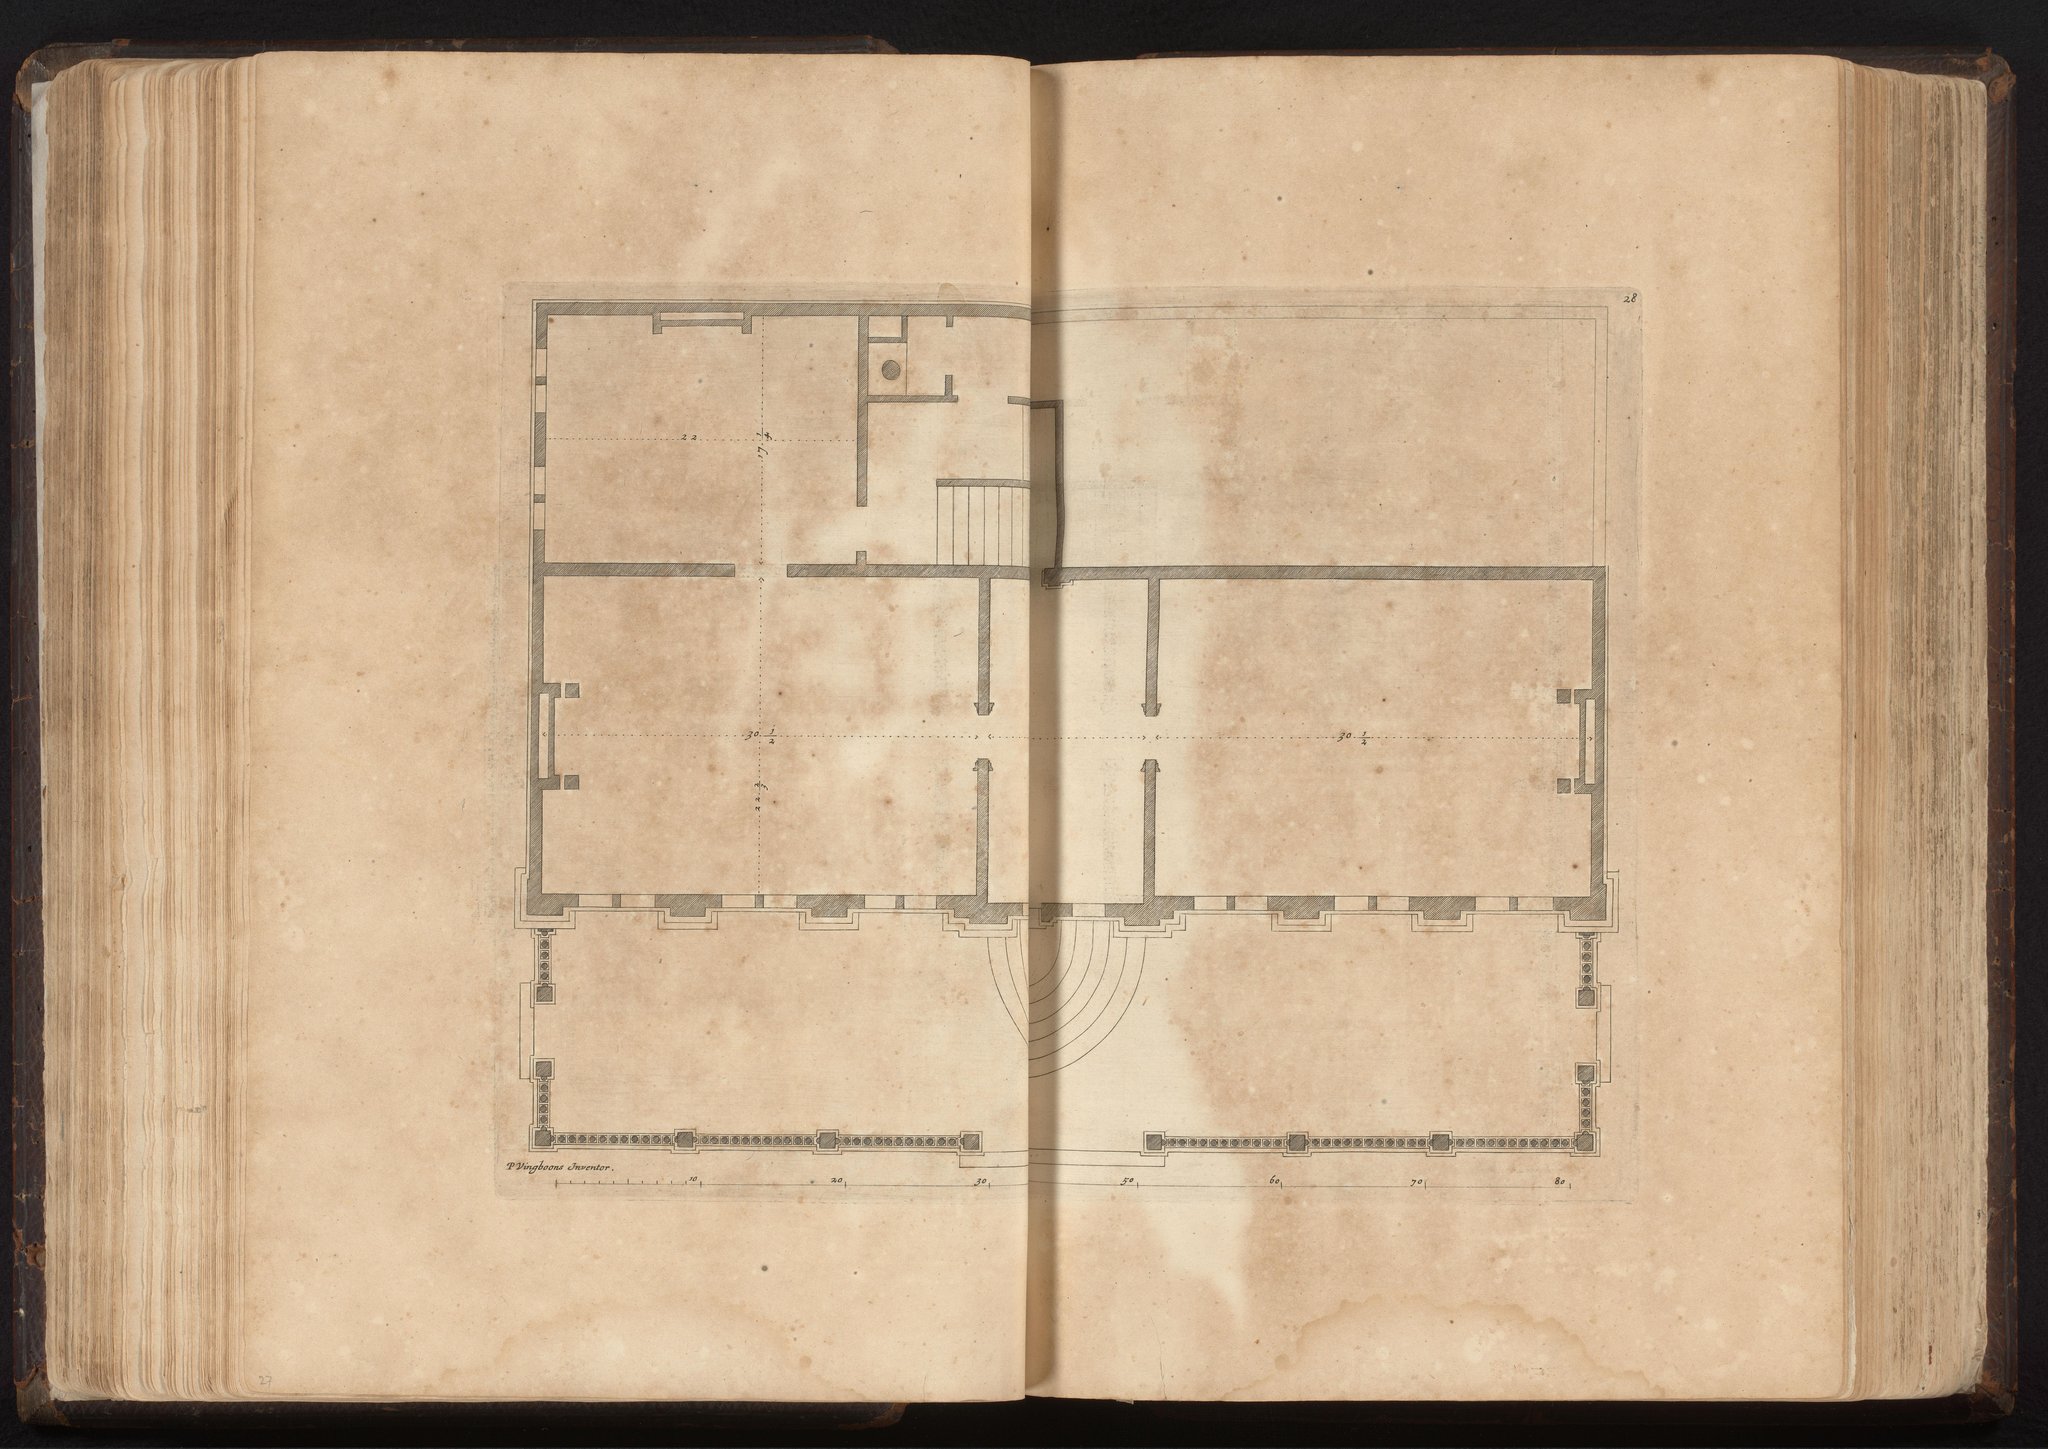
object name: print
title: Plattegrond van het landhuis Westwijck te Purmer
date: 1648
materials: paper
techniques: engraving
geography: amsterdam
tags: plan ~ architecture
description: Prent uit: Afbeelsels der voornaemste gebouwen uyt alle die Philips Vingboons geordineert heeft. Amsterdam: Philips en Johannes Vinckboons en Johannes Willemszoon Blaeu, 1648.